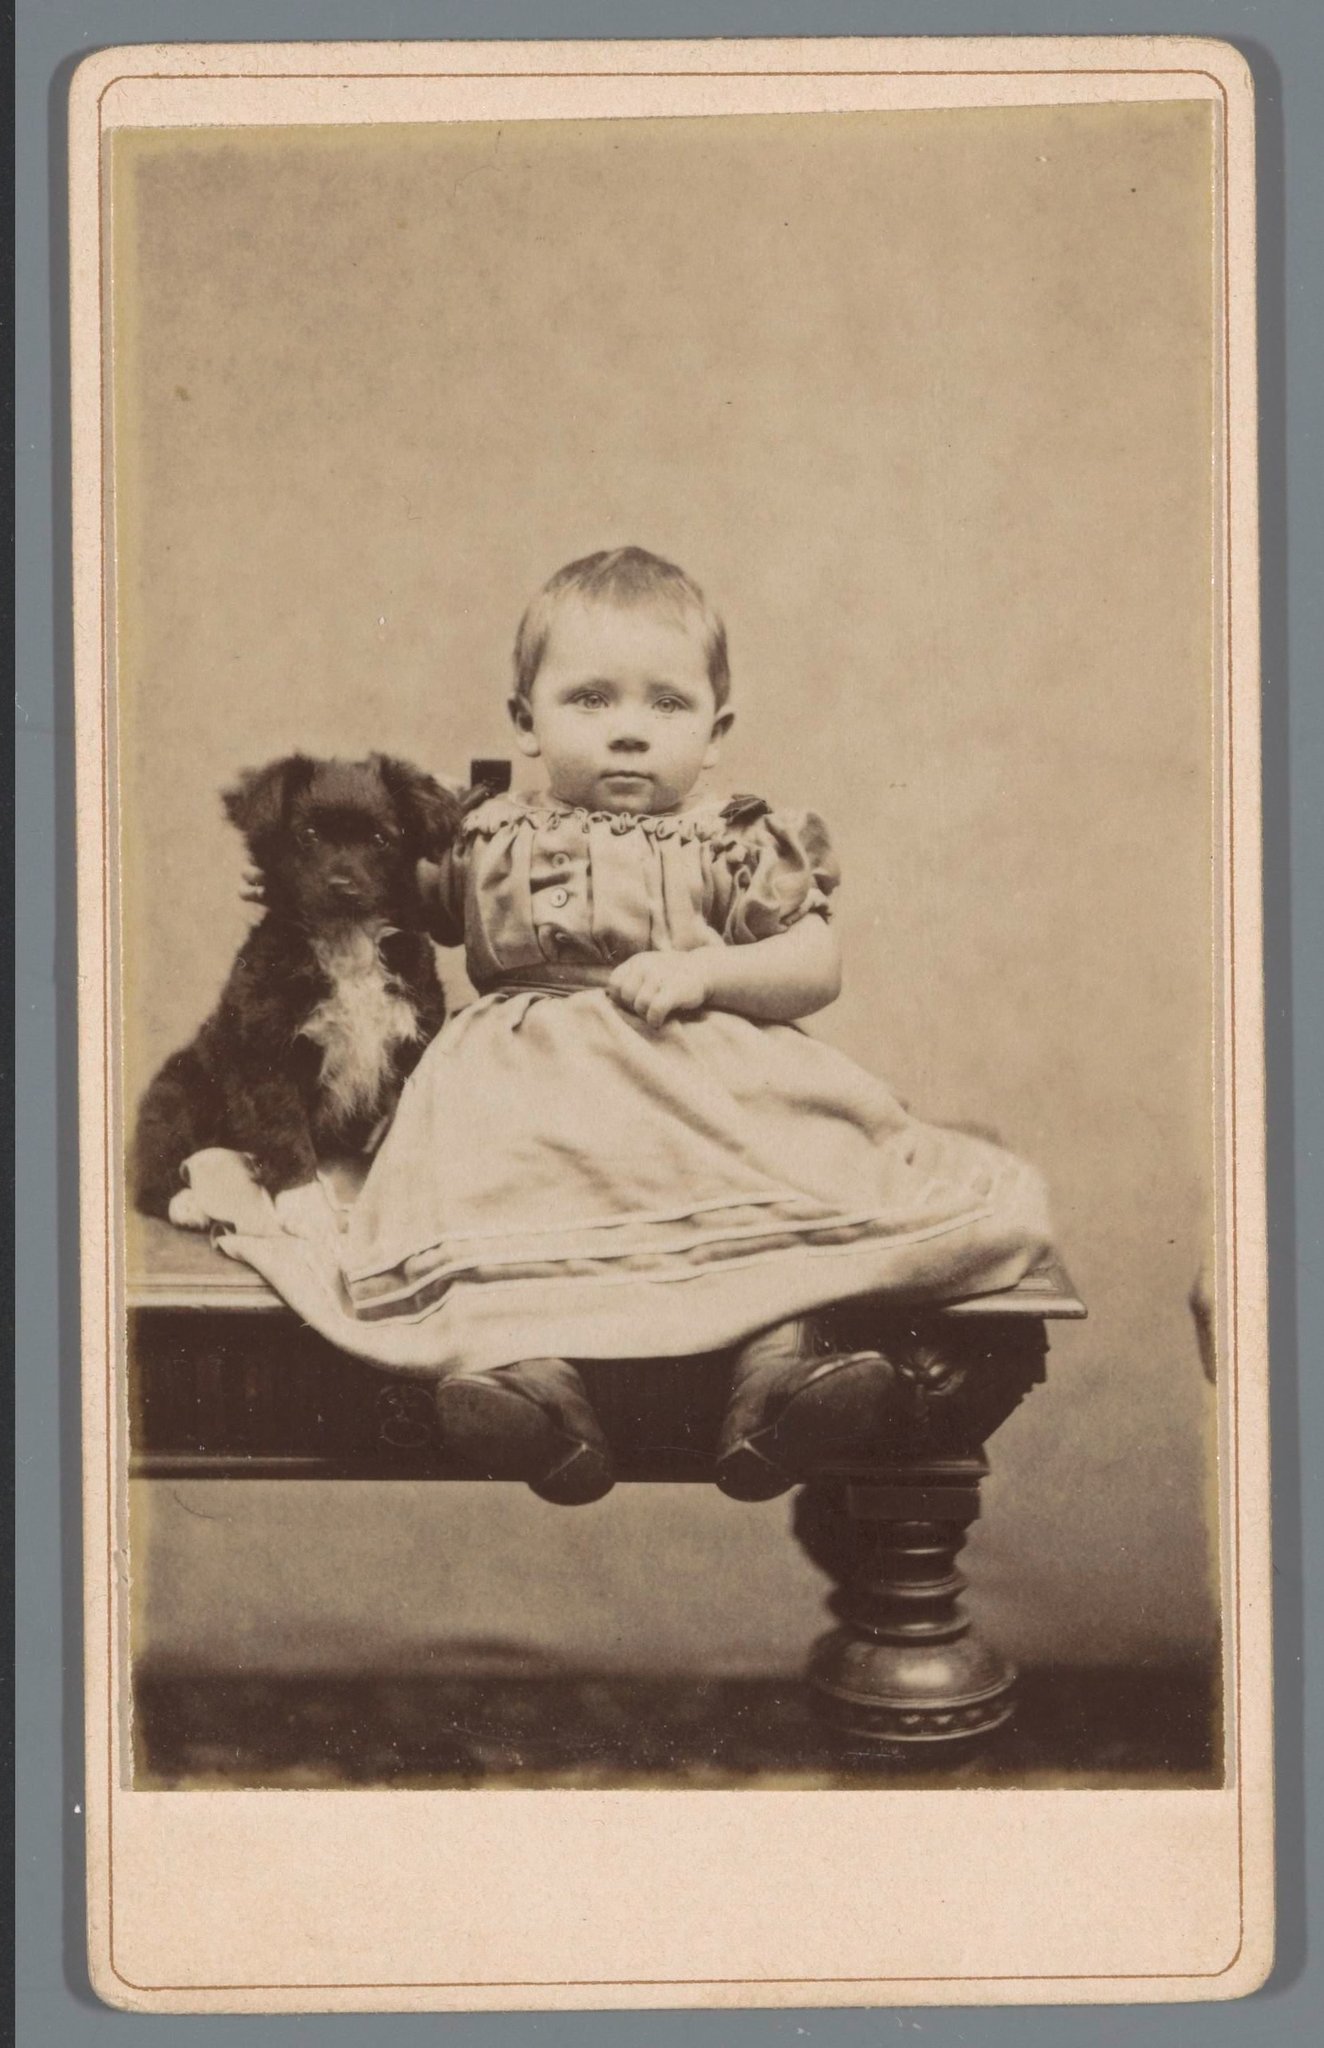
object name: carte de visite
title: Portret van een onbekend kind met hond op tafel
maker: hermanus jodocus weesing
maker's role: fotograaf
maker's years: 1844-1910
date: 1868-1900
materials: cardboard, celluloid, paper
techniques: albumen print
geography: amsterdam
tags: child, anonymous historical person portrayed, dog, amsterdam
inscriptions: inscription: ‘H.J. Weesing/ Photograaf/ Binnen Brouwerstraat 5,/ Amsterdam.’